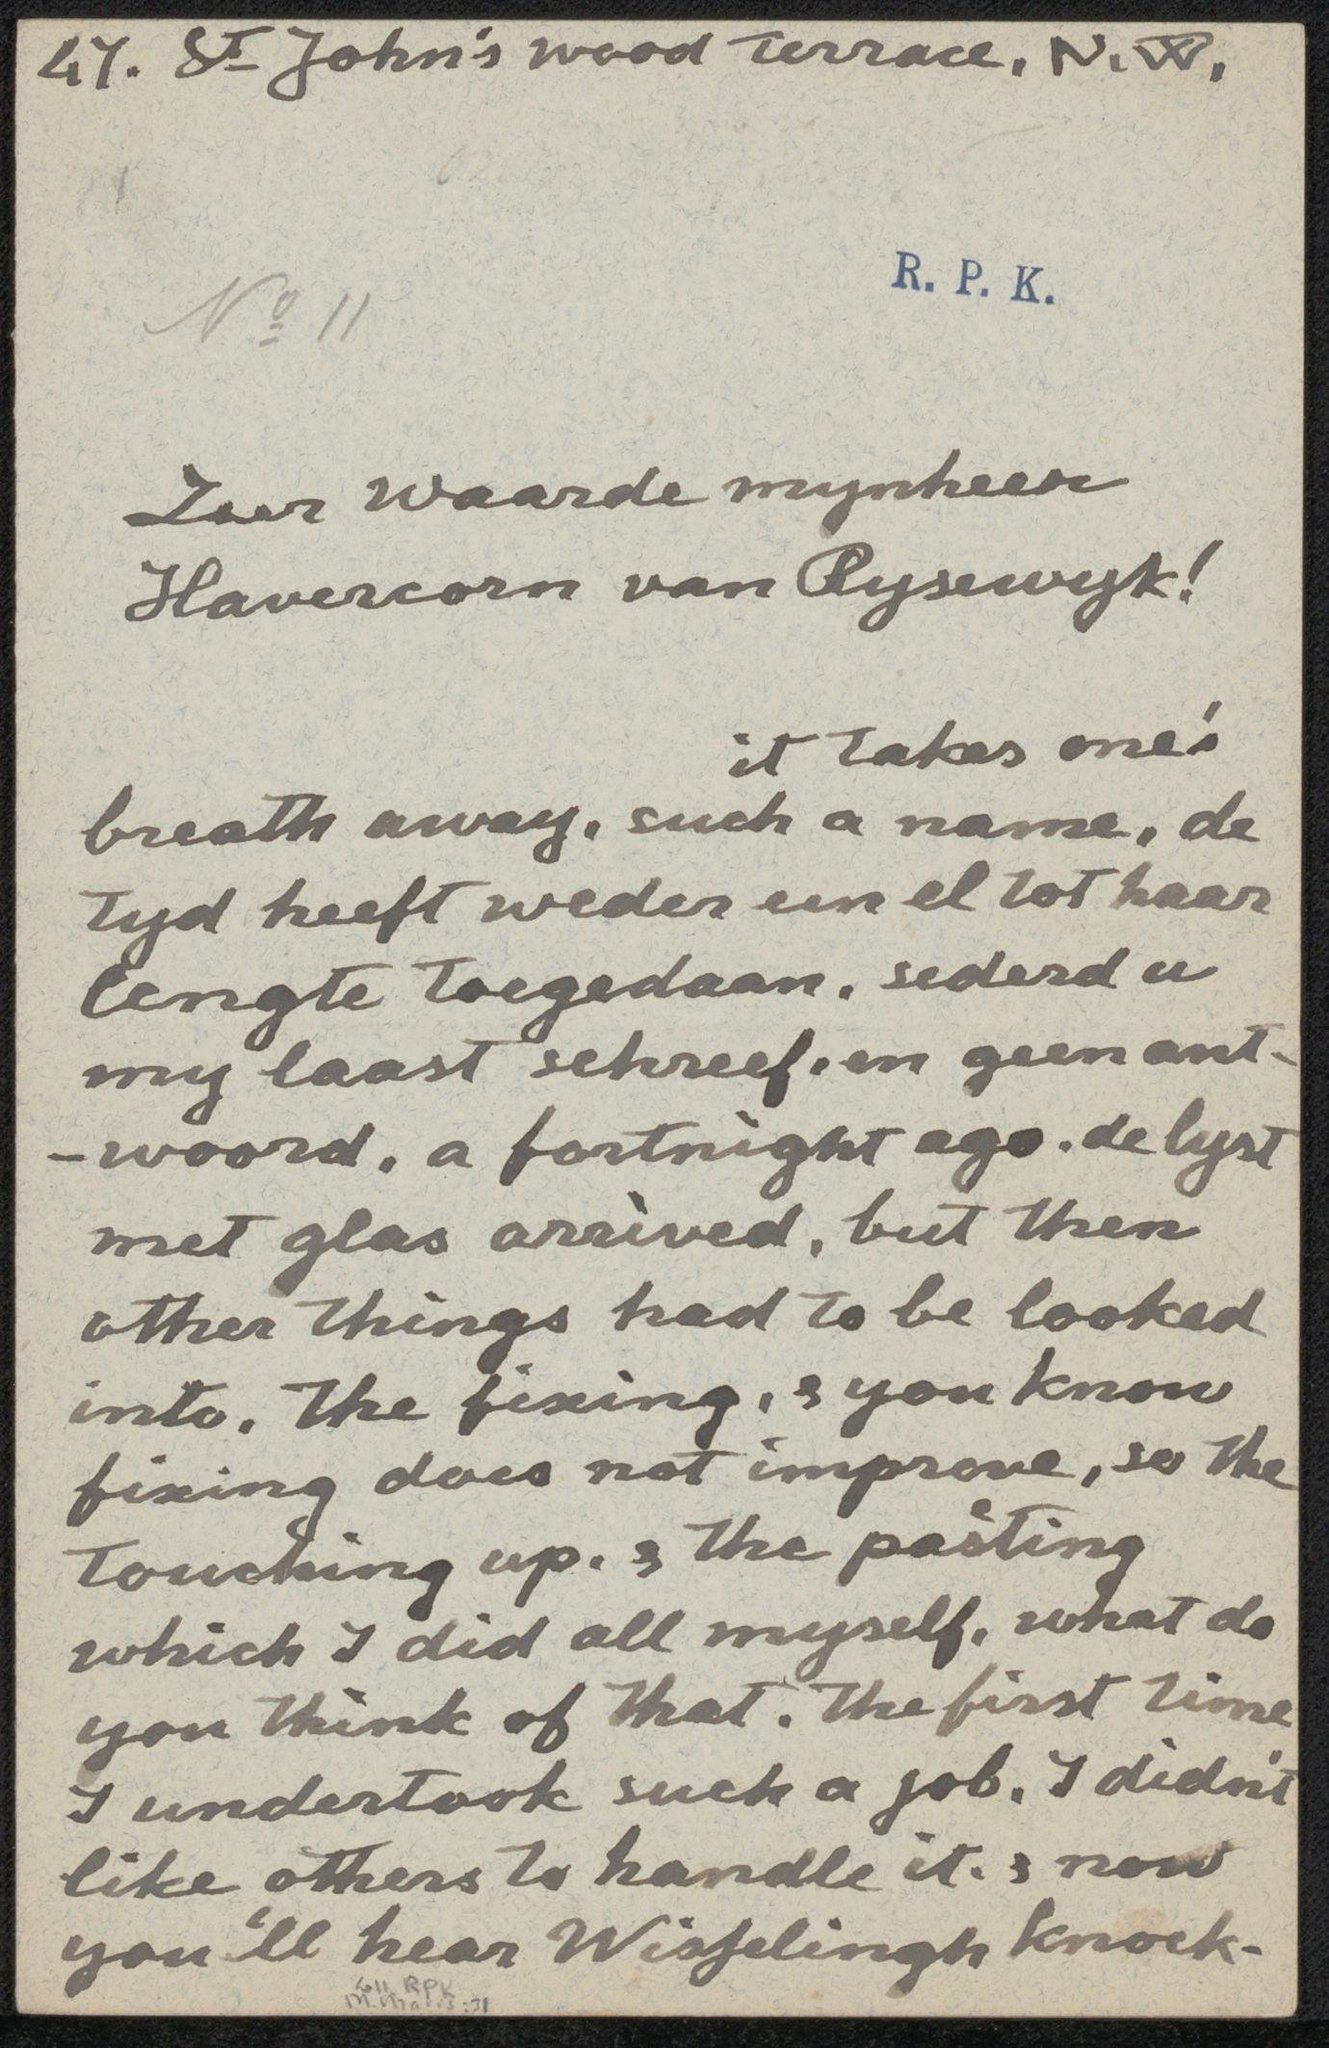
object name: letter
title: Brief aan Pieter Haverkorn van Rijsewijk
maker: matthijs maris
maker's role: draughtsman, painter, print maker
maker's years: 1839-1917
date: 1883-1915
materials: ink, paper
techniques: pen, writing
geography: london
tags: amsterdam, paul joseph constantin gabriël, pieter haverkorn van rijsewijk, elbert jan van wisselingh, art trade, art shop, painting (including book-illumination, miniature-painting), money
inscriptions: collector's mark: Lugt 2233